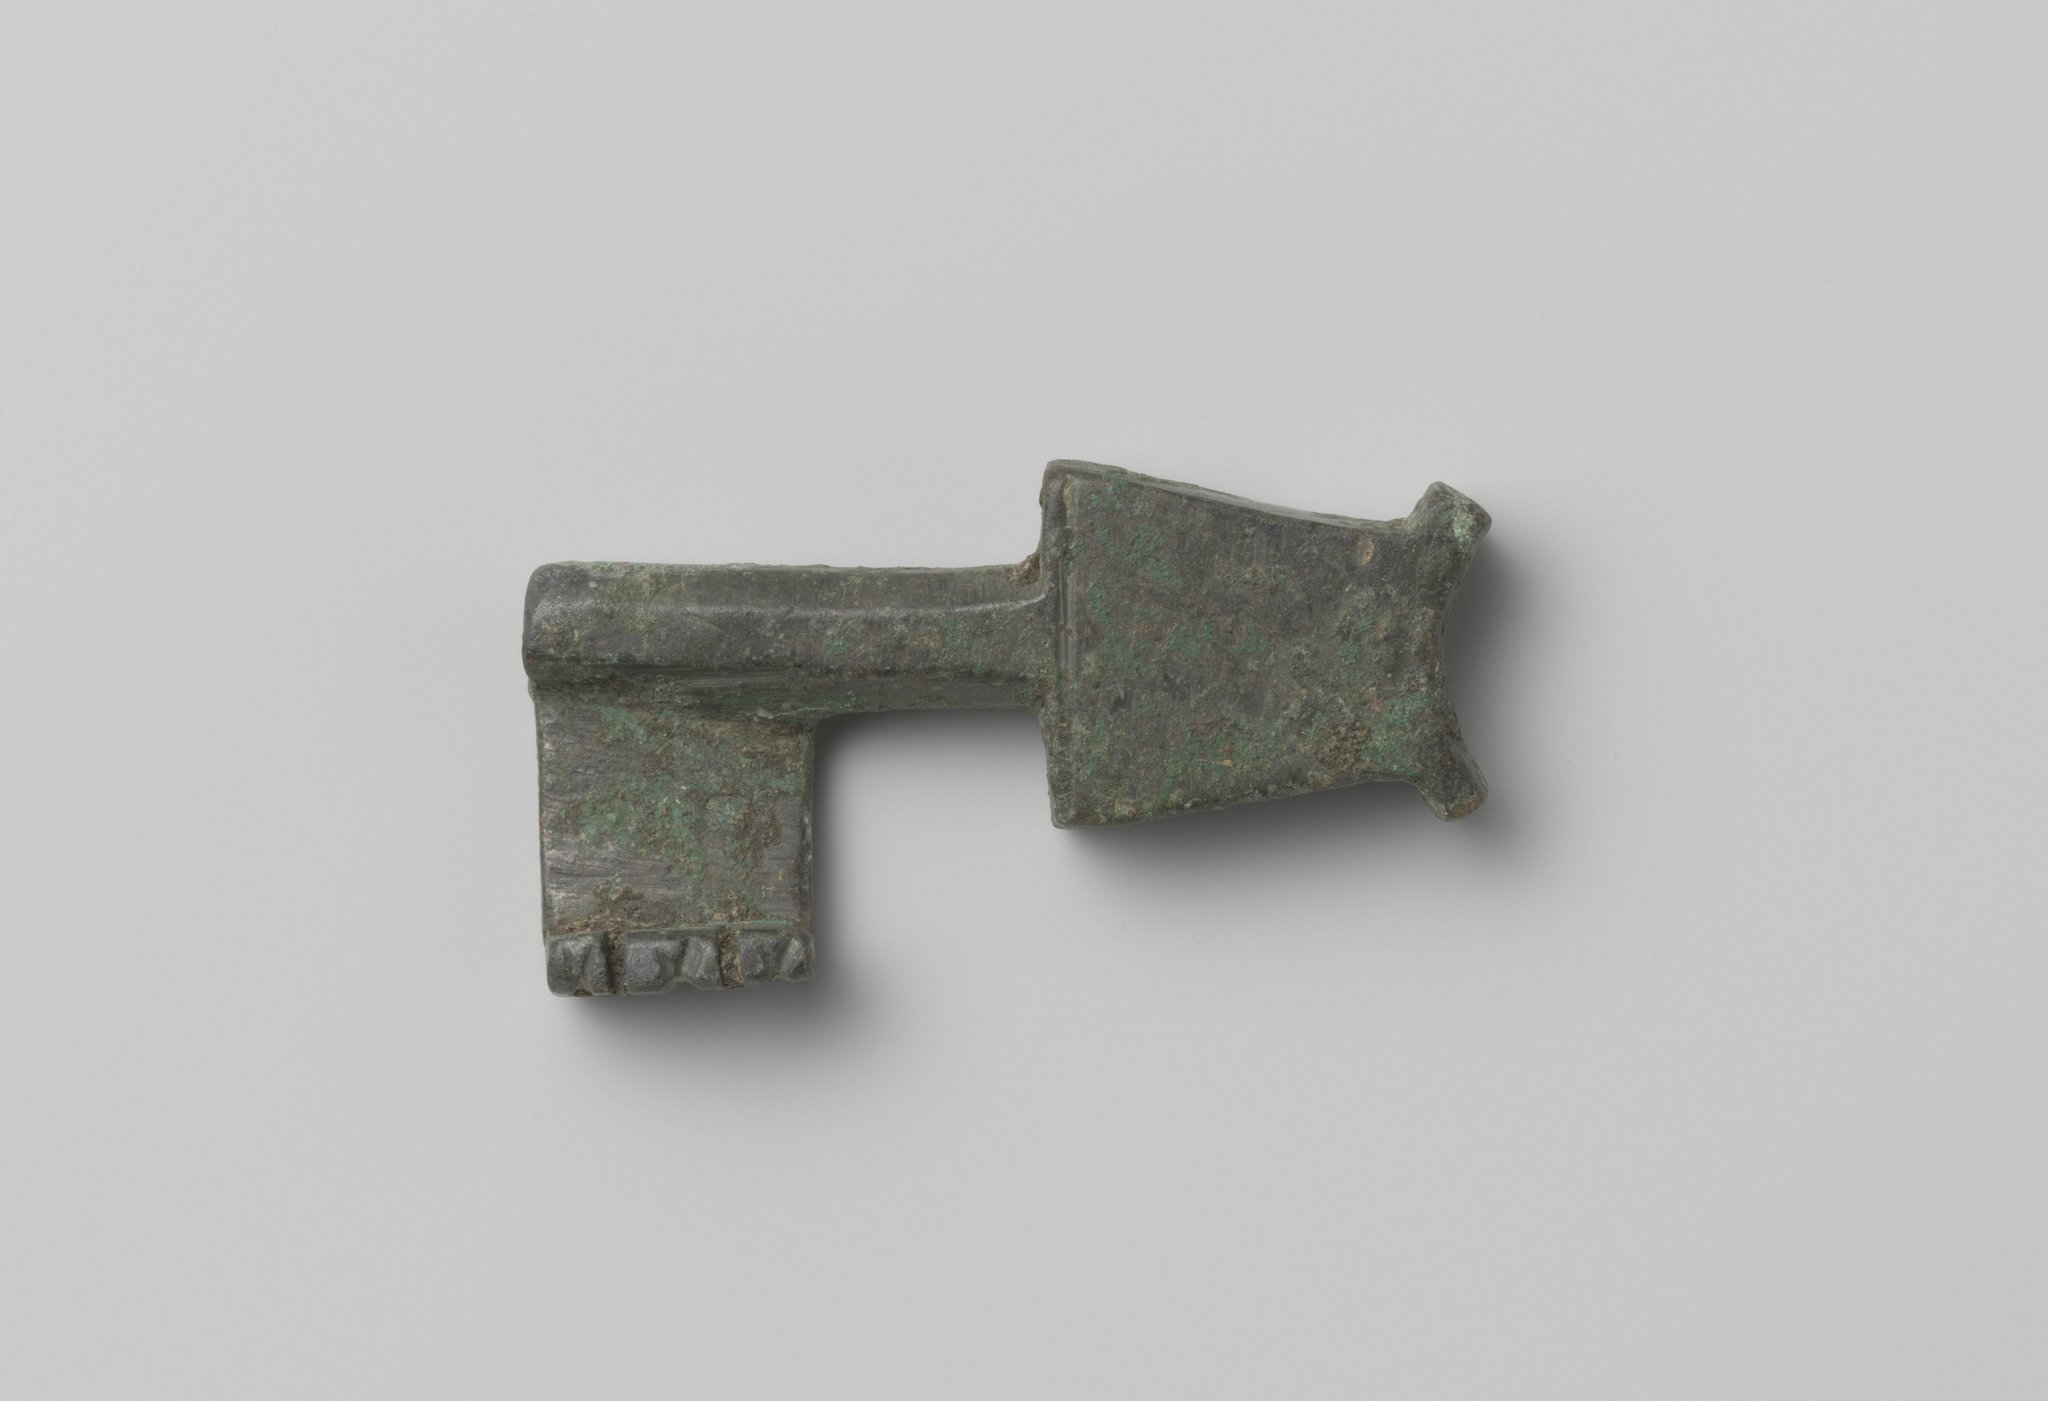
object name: pipe key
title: Pijpsleutel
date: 1400-1950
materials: bronze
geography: rome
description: Pijpsleutel met greep op ronde schacht, massieve vierkante baard, met rechthoekig daarop geplaatste tanden.